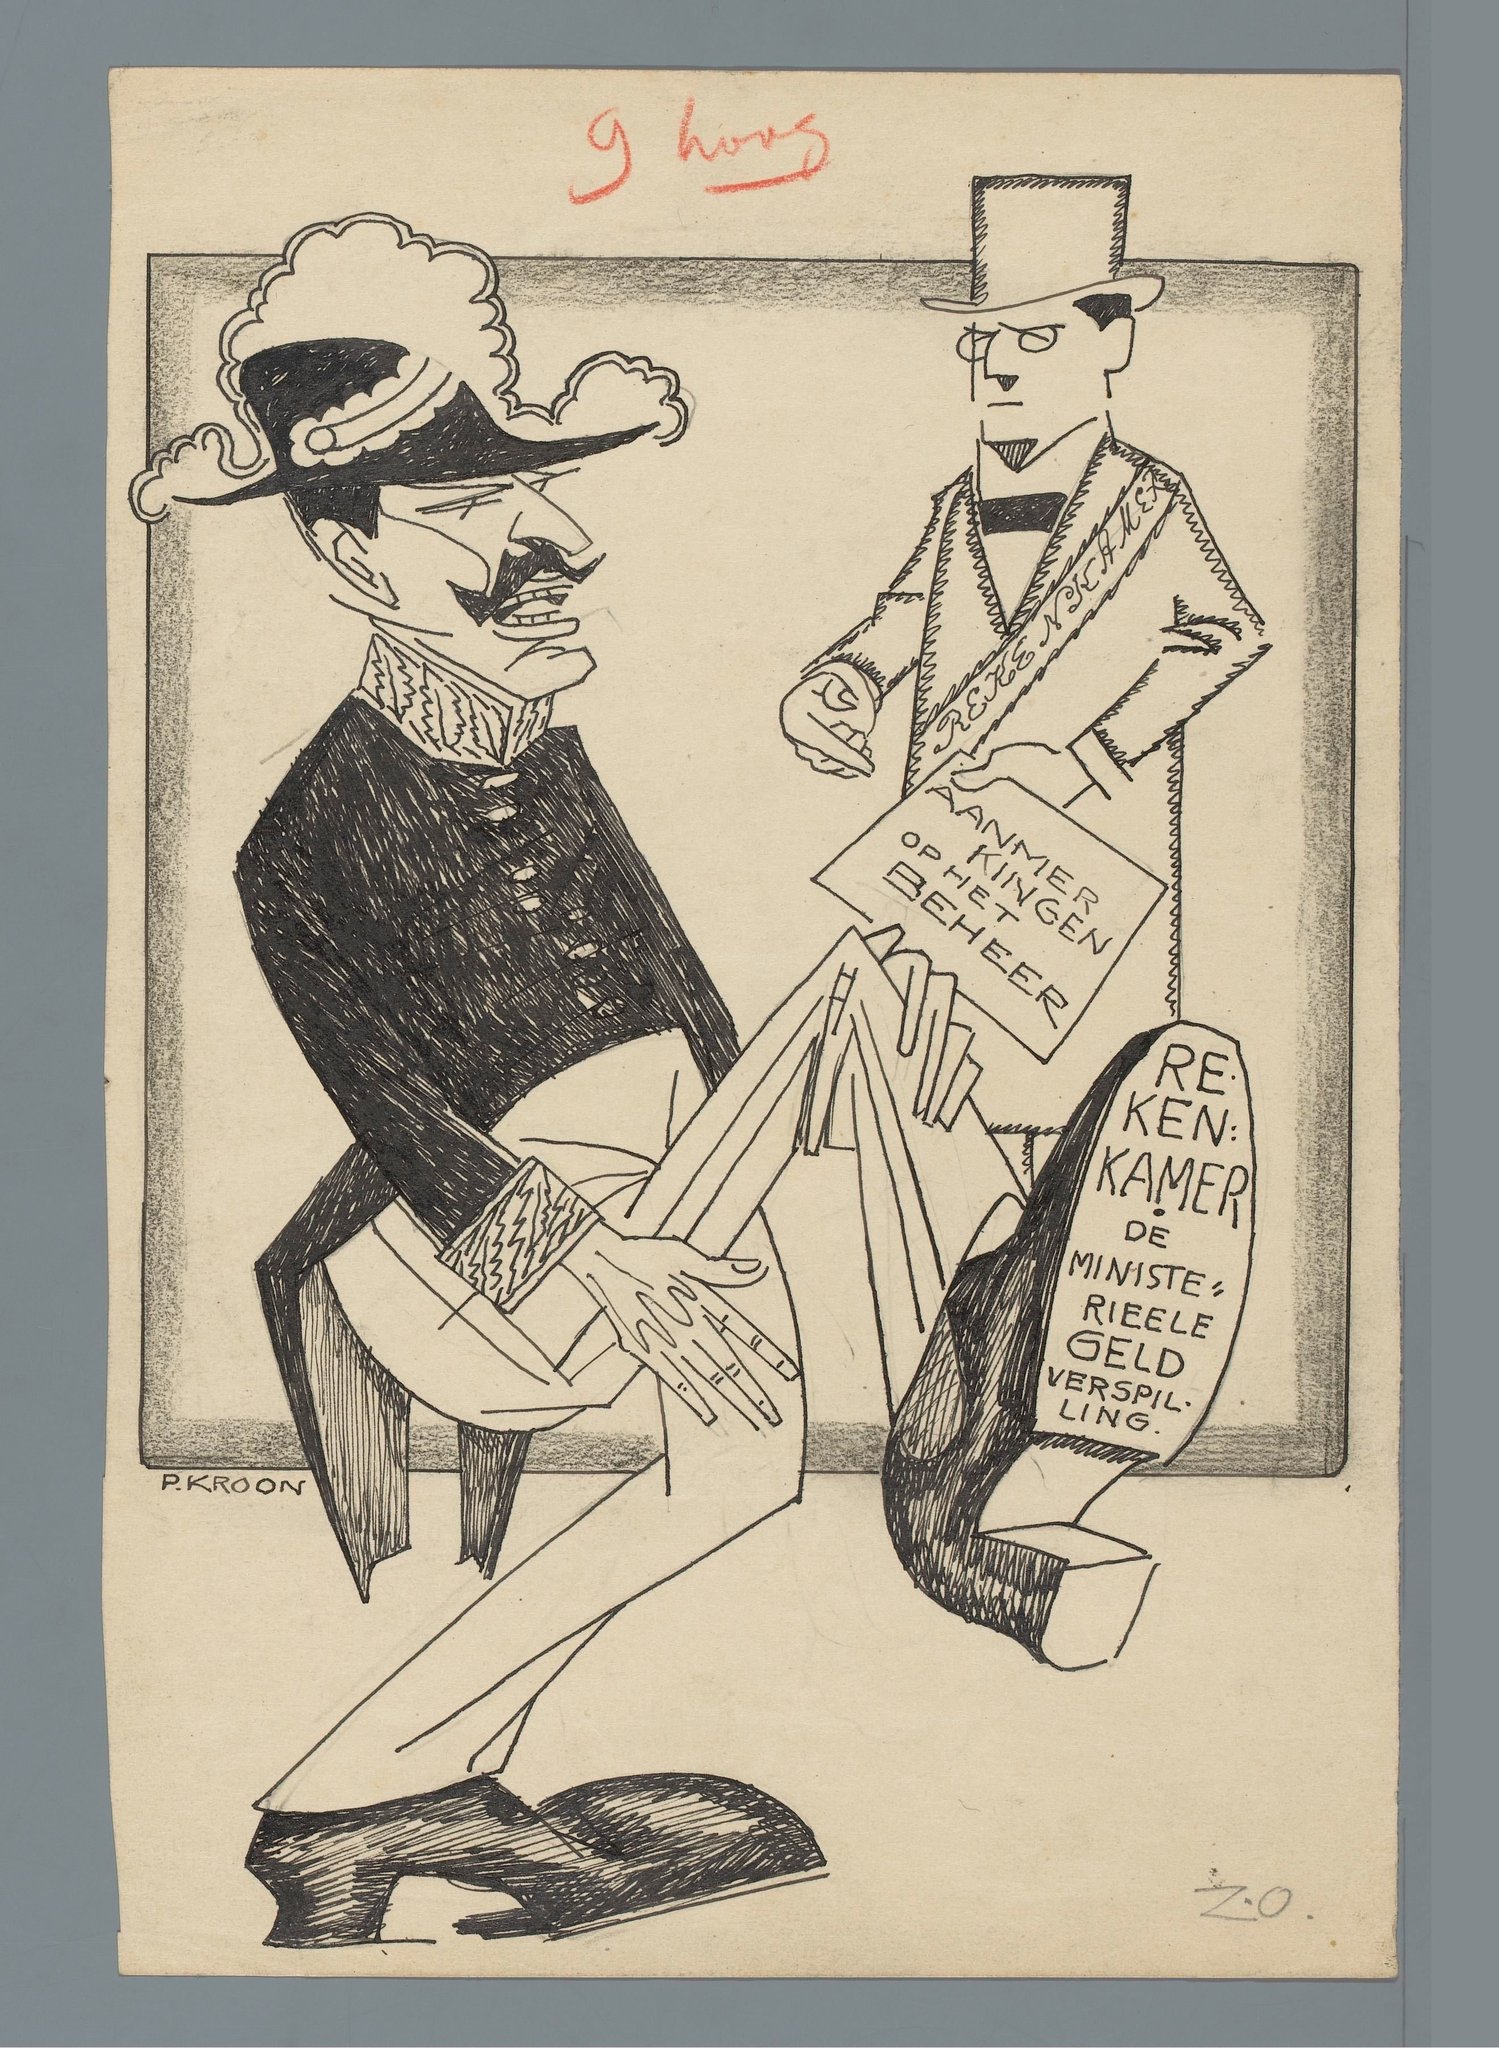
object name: cartoon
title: Contrôle op 's landsgelden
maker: patricq kroon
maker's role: draughtsman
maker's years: 1862-1941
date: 1920-1930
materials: chalk, ink, paper, pencil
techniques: pen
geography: netherlands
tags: minister ~ government, political caricatures and satires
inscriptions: inscription: ‘Contrôle op 's landsgelden / Zijne Excellentie: Die lap ik aan mijn laars!’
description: De Rekenkamer wijst een minister op hun aanmerkingen op het financiële beheer. Ontwerp voor een politieke spotprent.